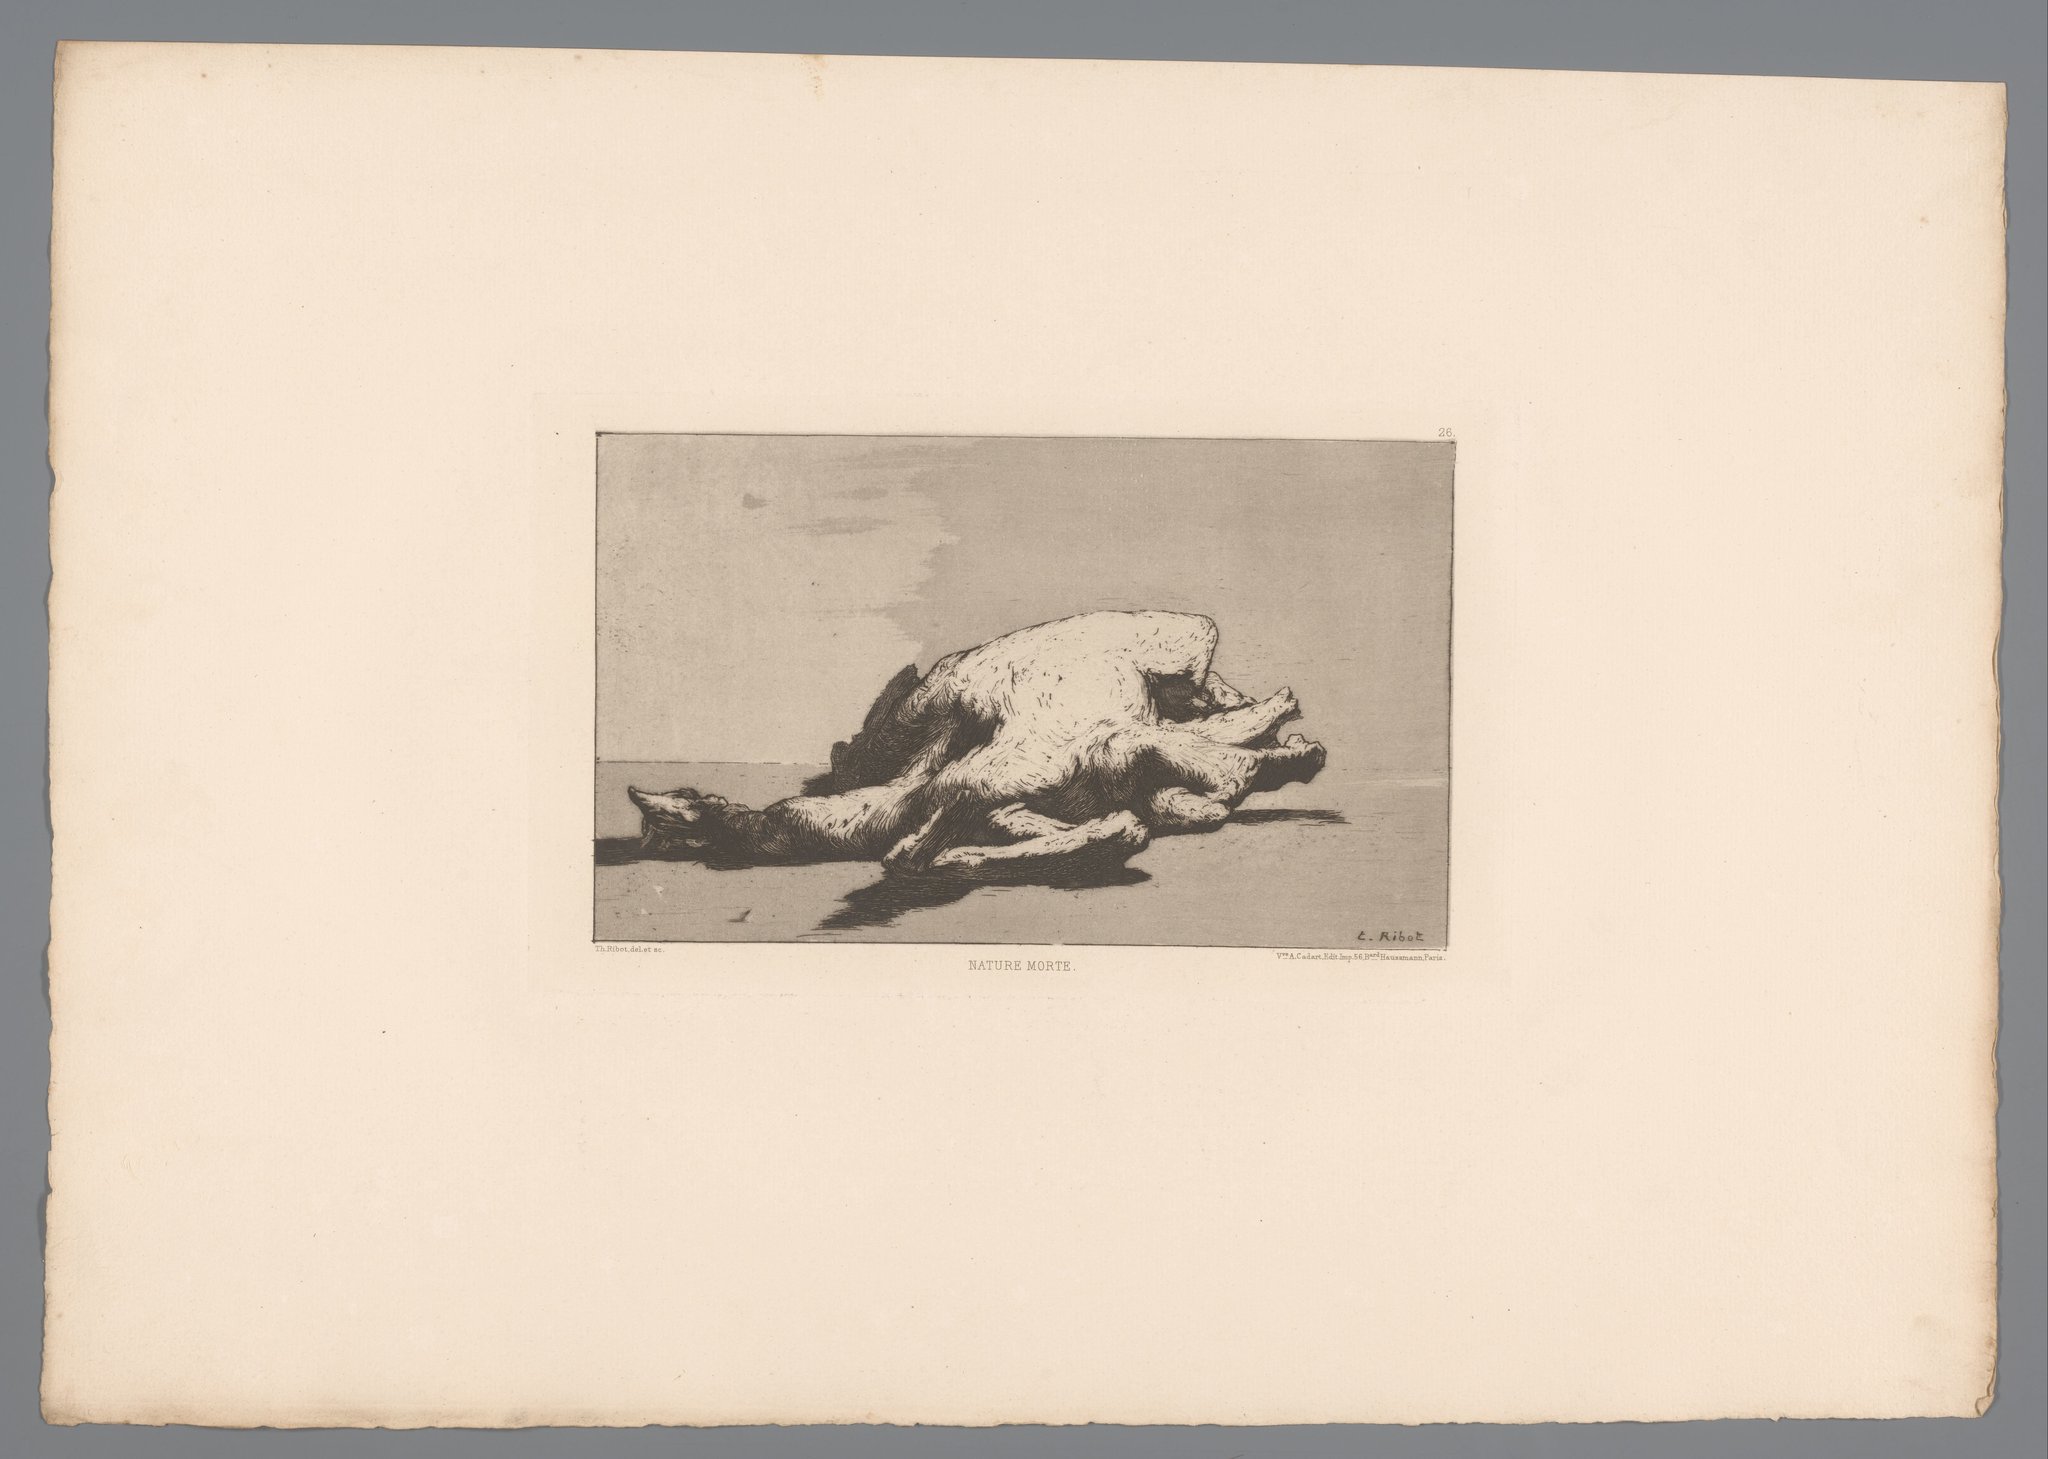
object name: print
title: Franse etsen uit 1878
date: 1878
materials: paper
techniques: aquatint, drypoint, etching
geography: paris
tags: fowl (cock, hen, chicken, etc.), foodstuffs; still life of foodstuffs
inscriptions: collector's mark: ‘AFE v S’, watermark, collector's mark: Lugt 2760, collector's mark: Lugt 2228